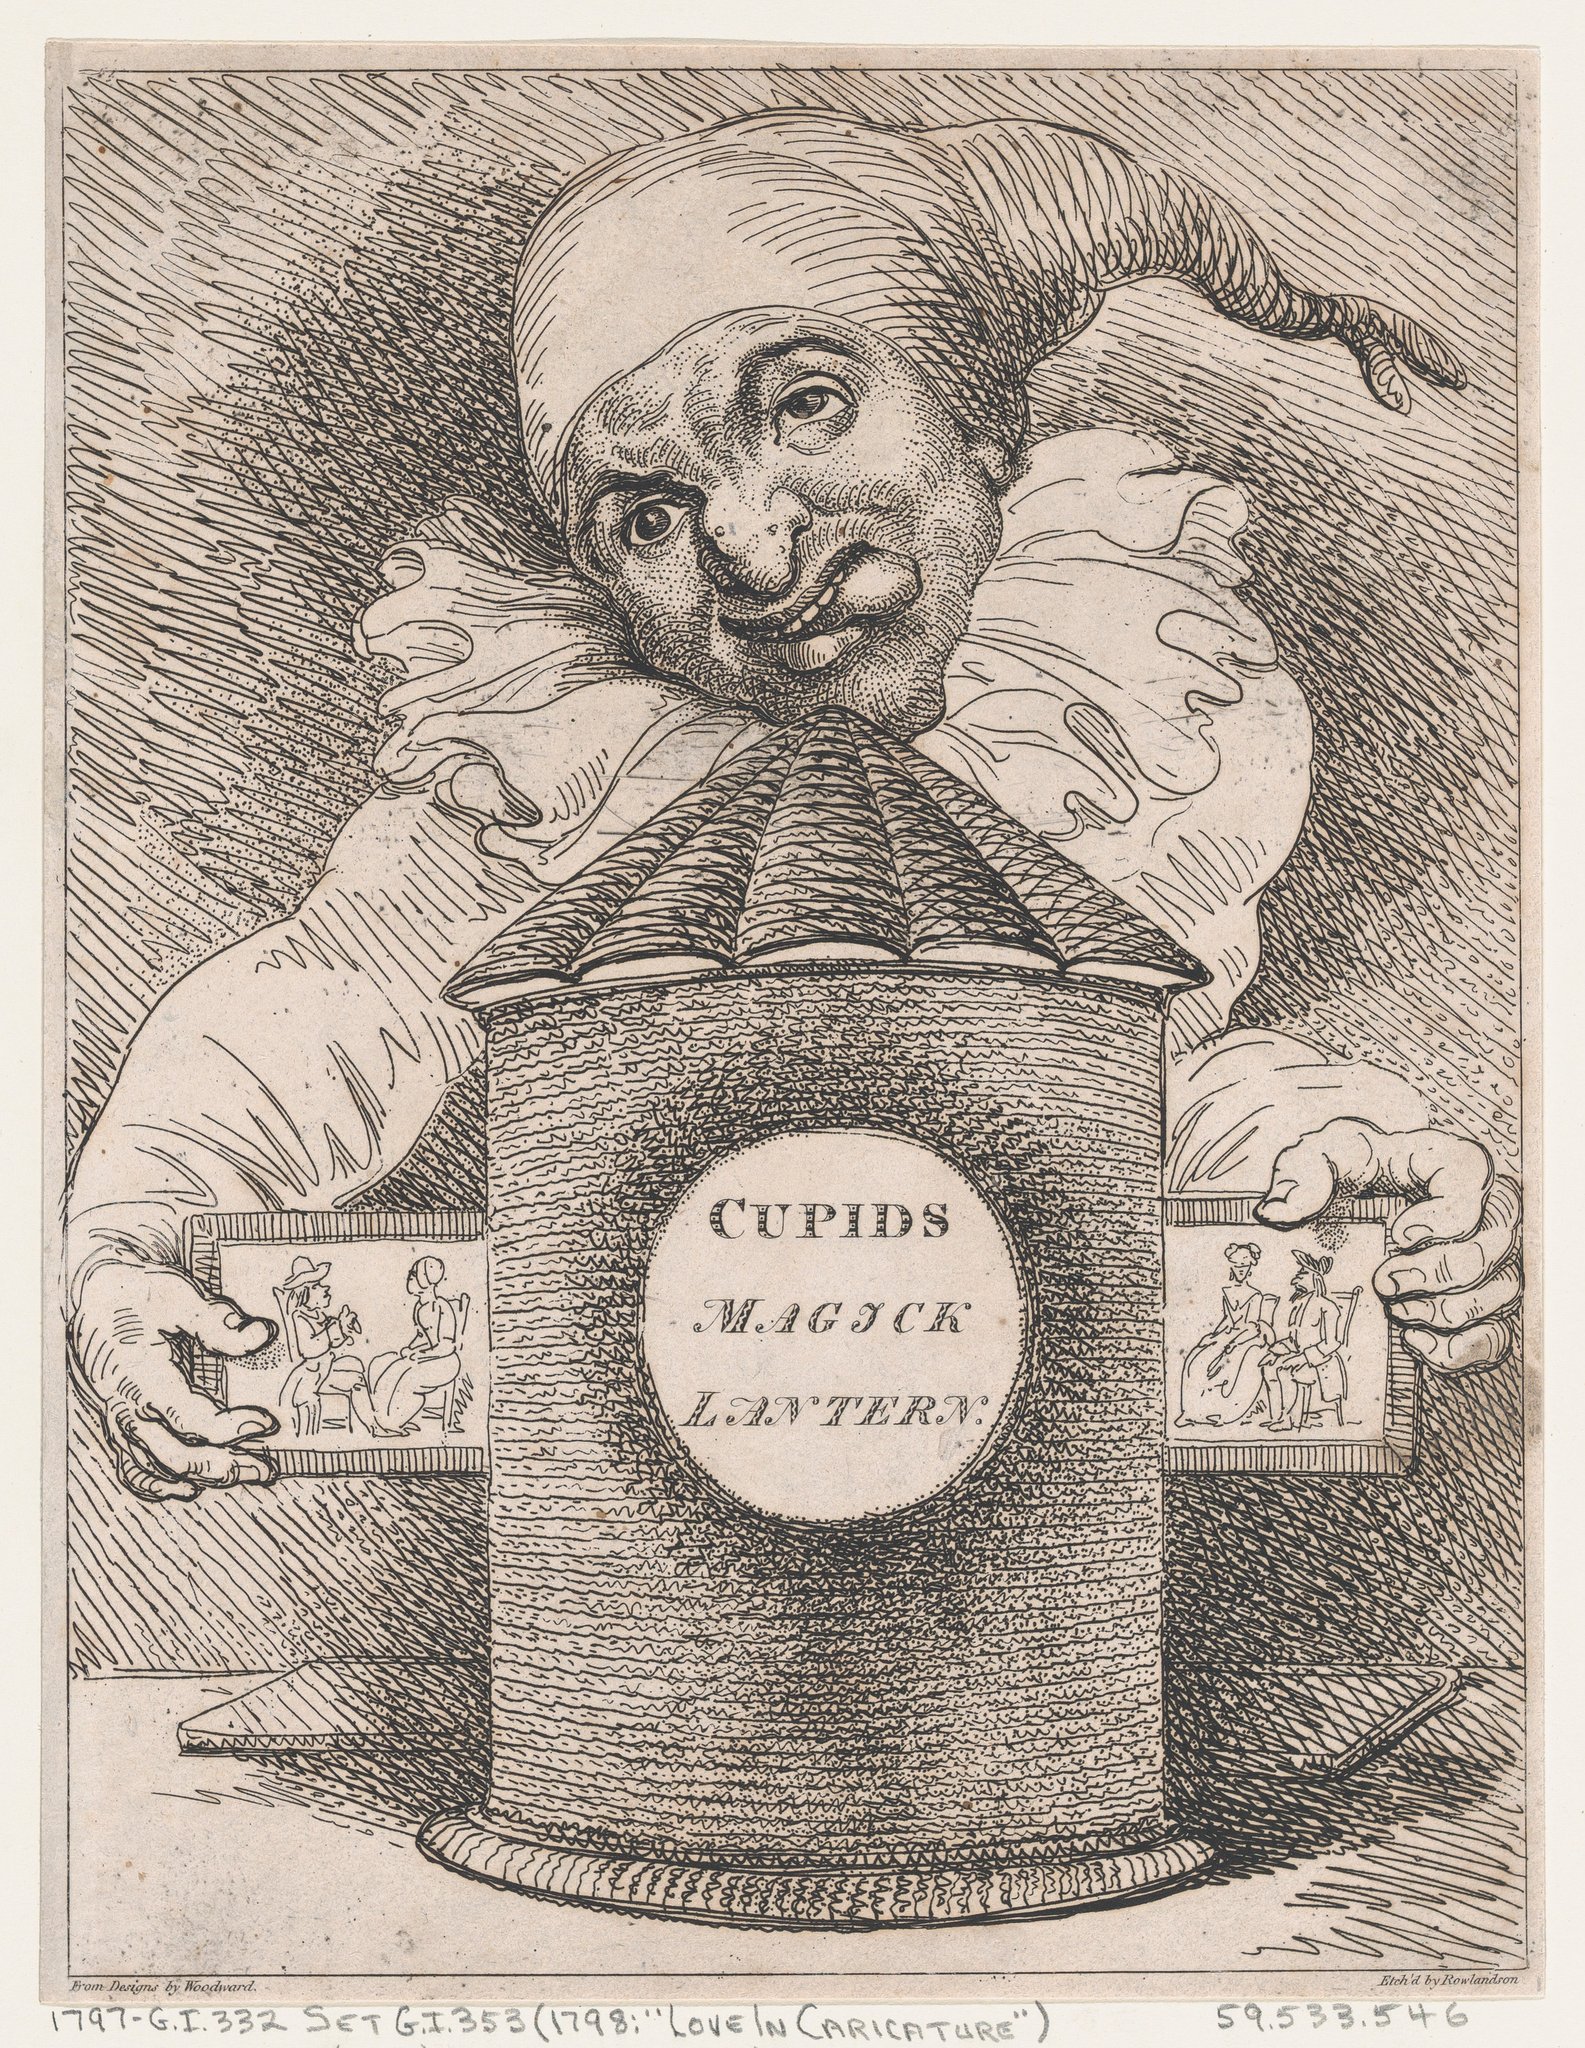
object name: print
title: Cupid's Magick Lantern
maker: thomas rowlandson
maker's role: artist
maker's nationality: british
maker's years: 1757-1827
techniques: aquatint, etching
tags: lanterns